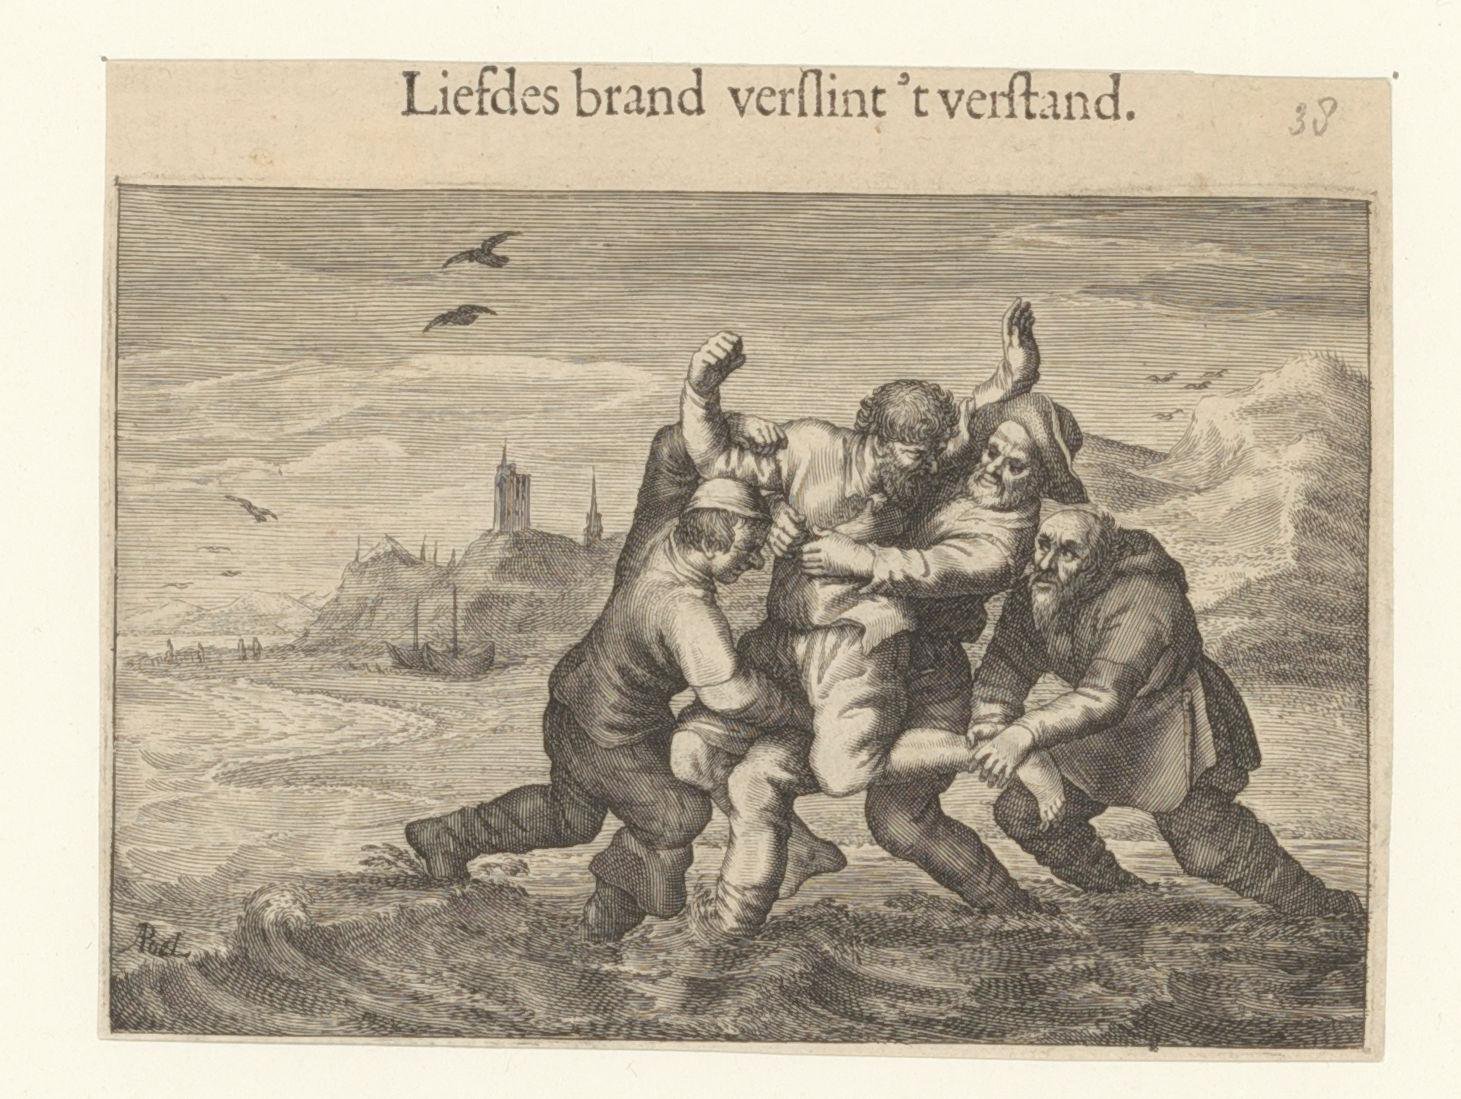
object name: book illustration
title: Drie mannen proberen een man in bedwang te houden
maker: abraham poel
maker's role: print maker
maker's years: 1601-1637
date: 1624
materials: paper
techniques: engraving, letterpress printing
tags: adult man, proverbs, sayings, etc., violent death, being killed; being mishandled and maltreated; seeking death, coast, lovesick lover, fighting, suicide out of despair, sea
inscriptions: collector's mark: Lugt 1641, stamp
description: Drie mannen proberen een man in bedwang te houden terwijl zij in zee staan. De in bedwang gehouden man probeert door liefdesverdriet zichzelf te verdrinken in de zee. Onderwerpsrubrieken binnen de Atlas Zeden en Gewoonten: Zeden en Gewoonten in engeren zin. Volksleven. Zinnebeeldige voorstellingen uit het volkleven op serieprenten. Maanden en diversen (allegorieën).